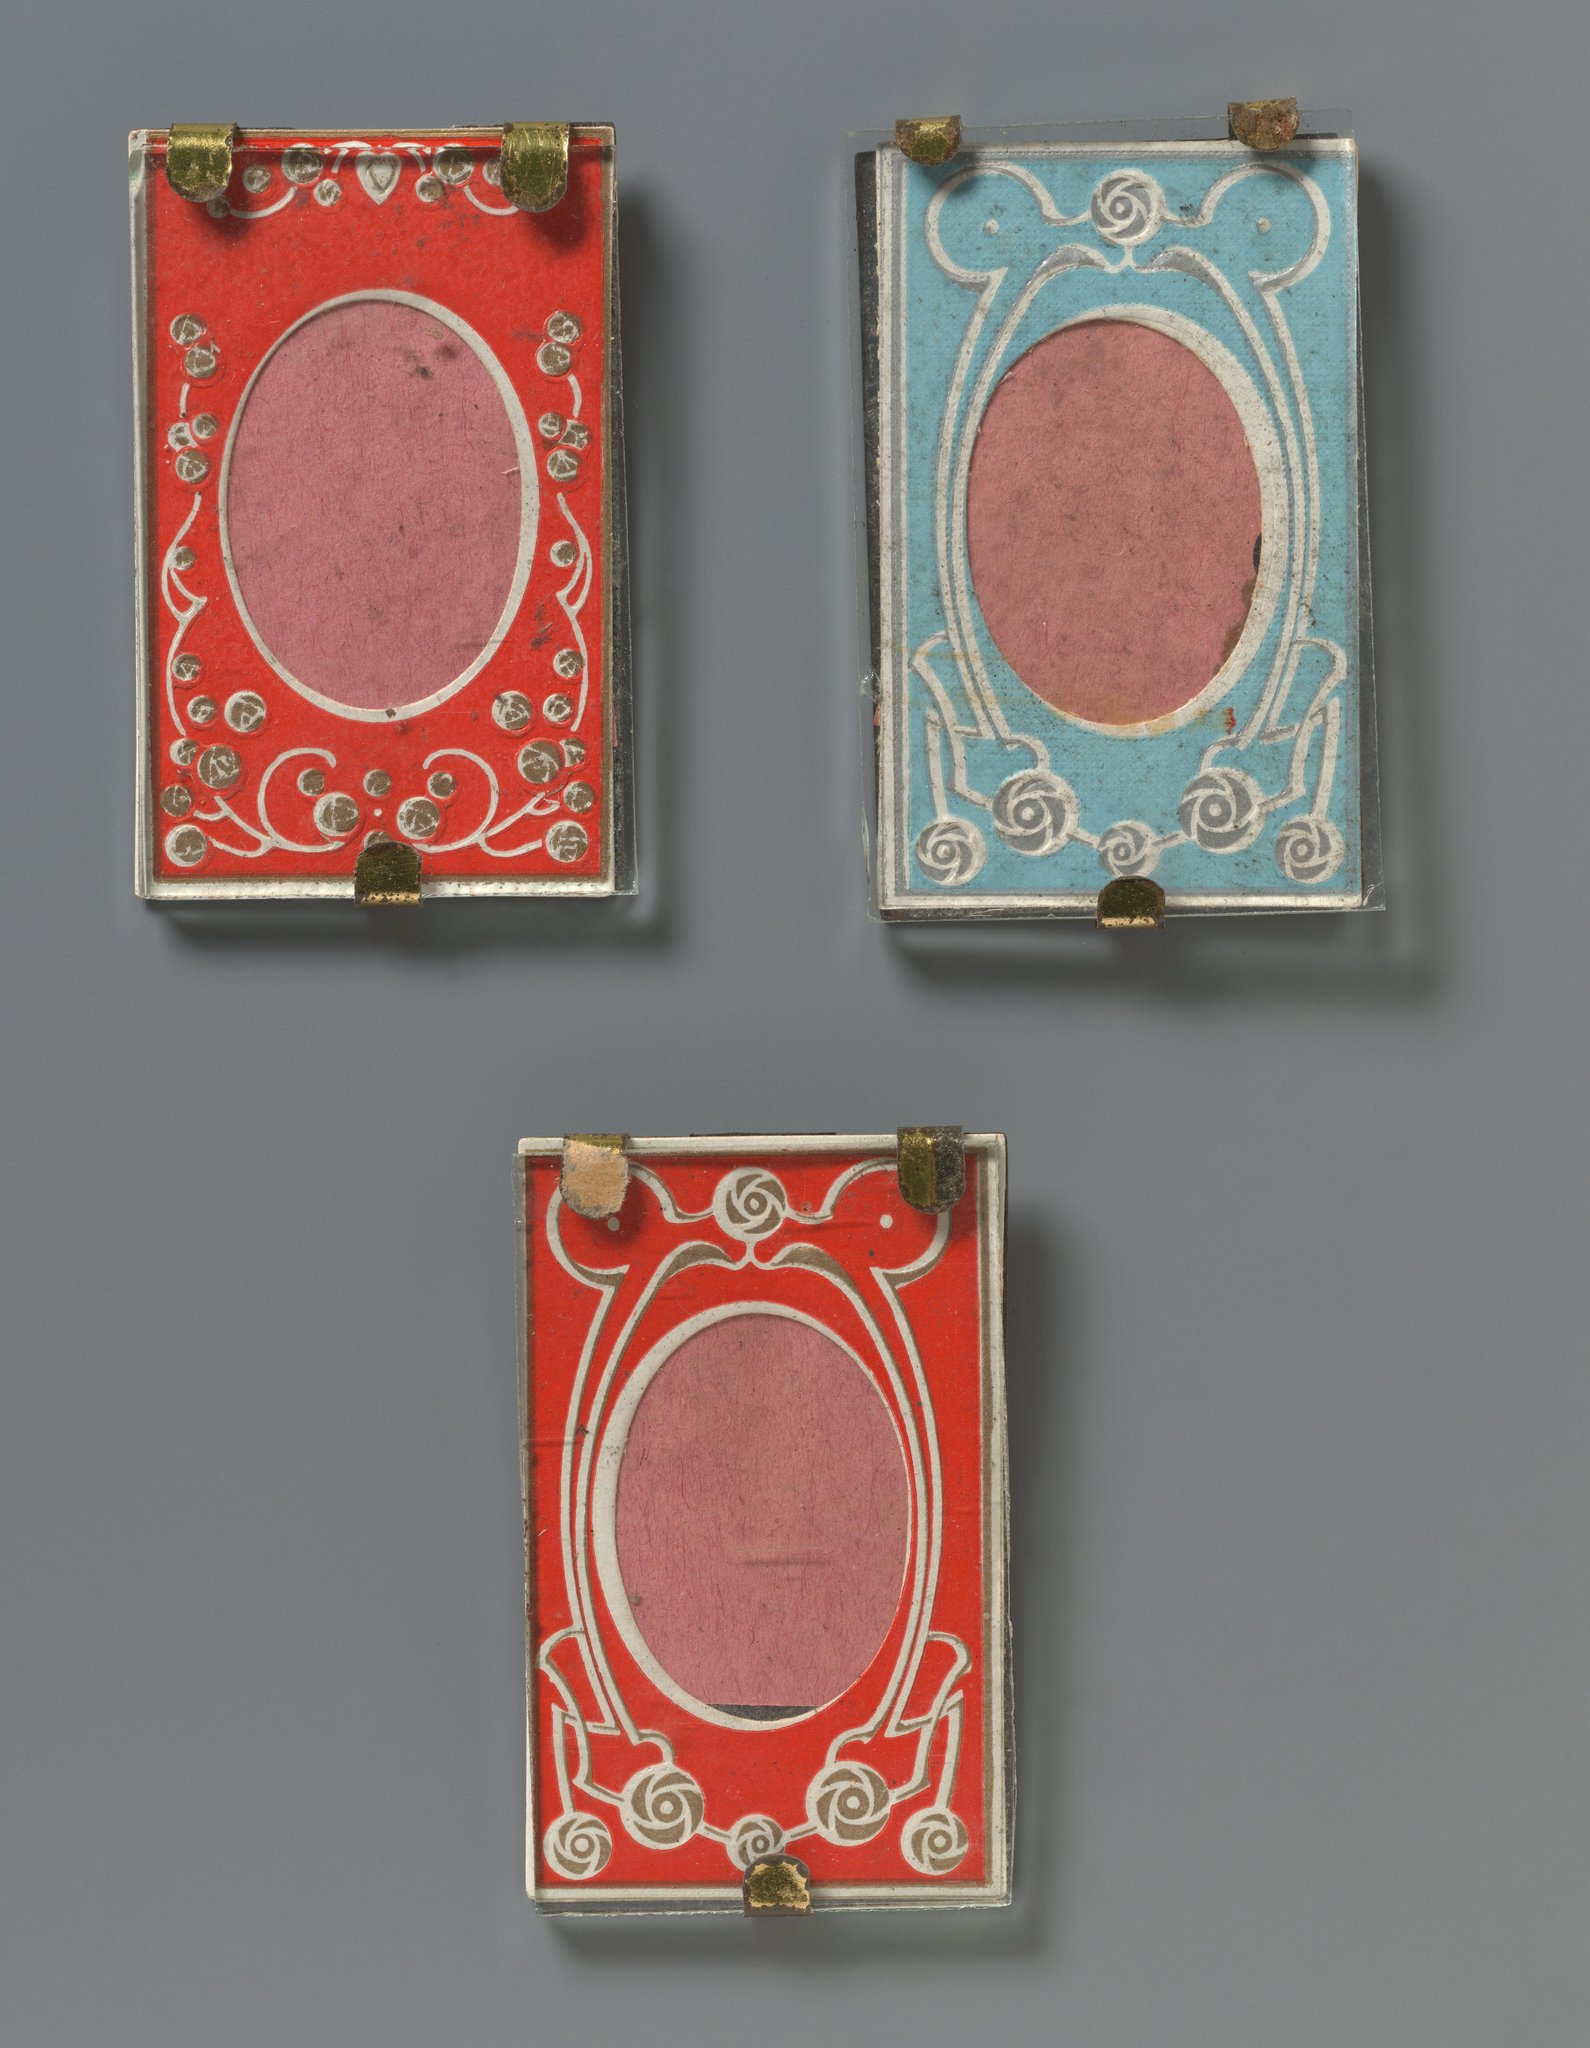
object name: frame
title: Drie lege miniatuurlijsten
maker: Anonymous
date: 1900-1920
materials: glass, metal, paper